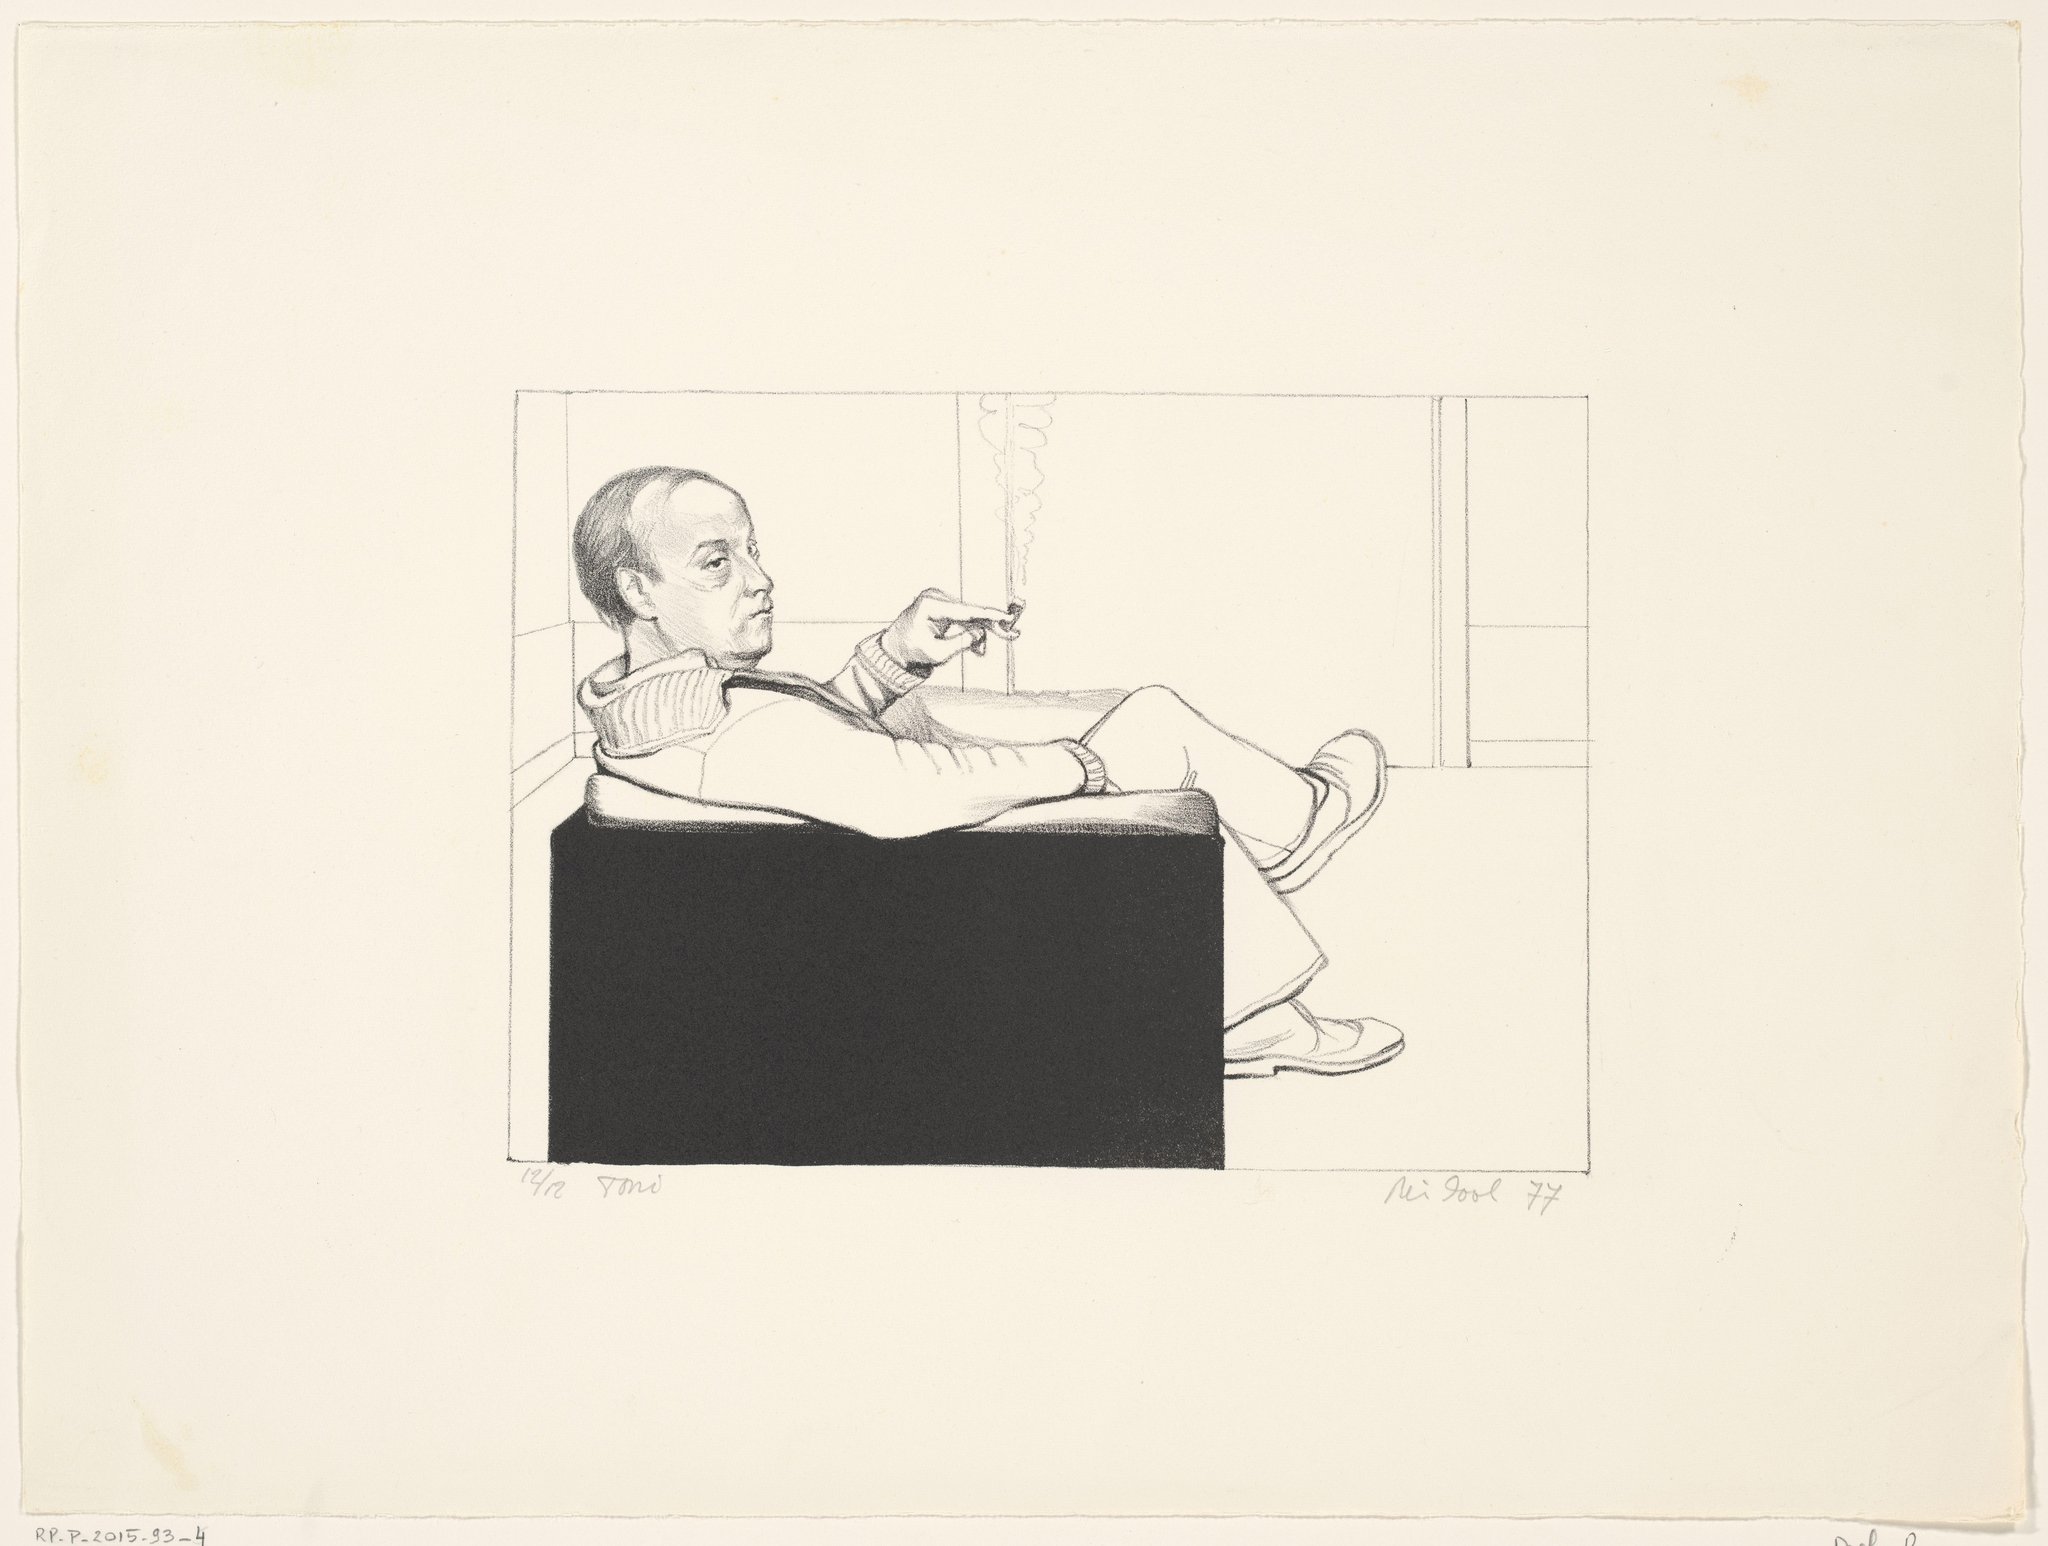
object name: print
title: Toni met sigaar zittend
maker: rein dool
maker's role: draughtsman, painter, print maker, sculptor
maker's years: 1933-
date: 1977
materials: paper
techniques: lithograph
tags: toni kraaienbrink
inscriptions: signature and date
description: Portret van de architect Toni Kraaienbrink.